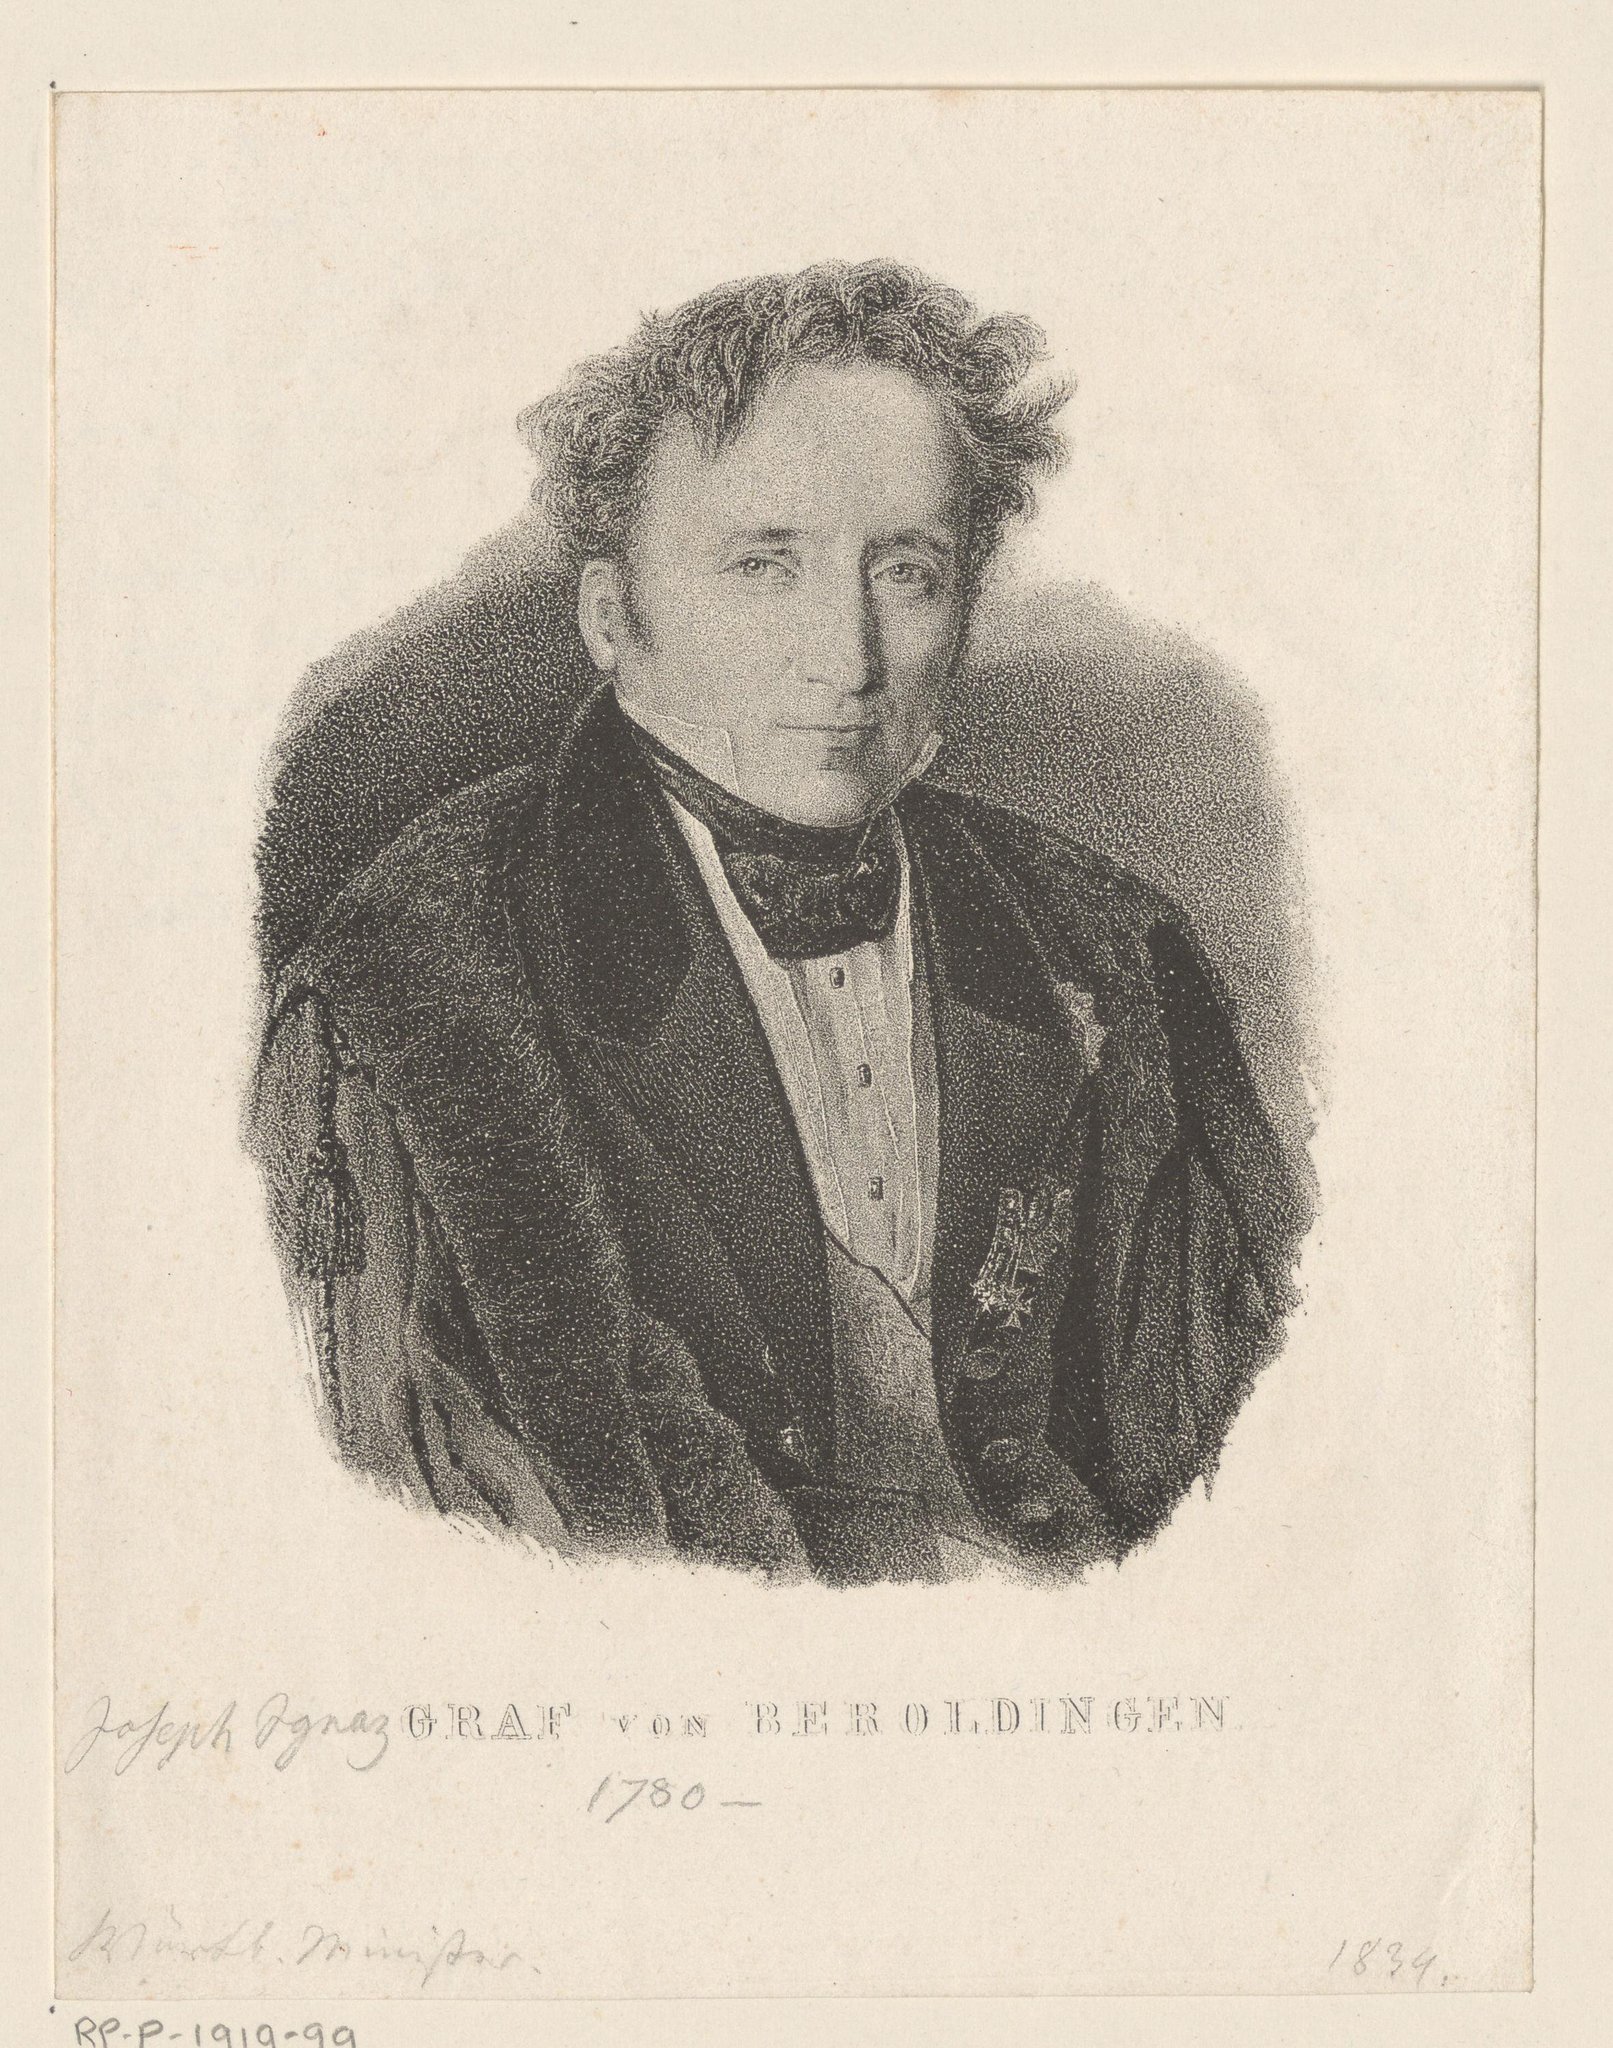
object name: print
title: Portret van Joseph Ignaz von Beroldingen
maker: Anonymous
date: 1800-1899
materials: paper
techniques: lithograph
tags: historical persons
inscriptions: inscription: ‘geb. zum Ellwangen 1780 [...]’, collector's mark: Lugt 2228